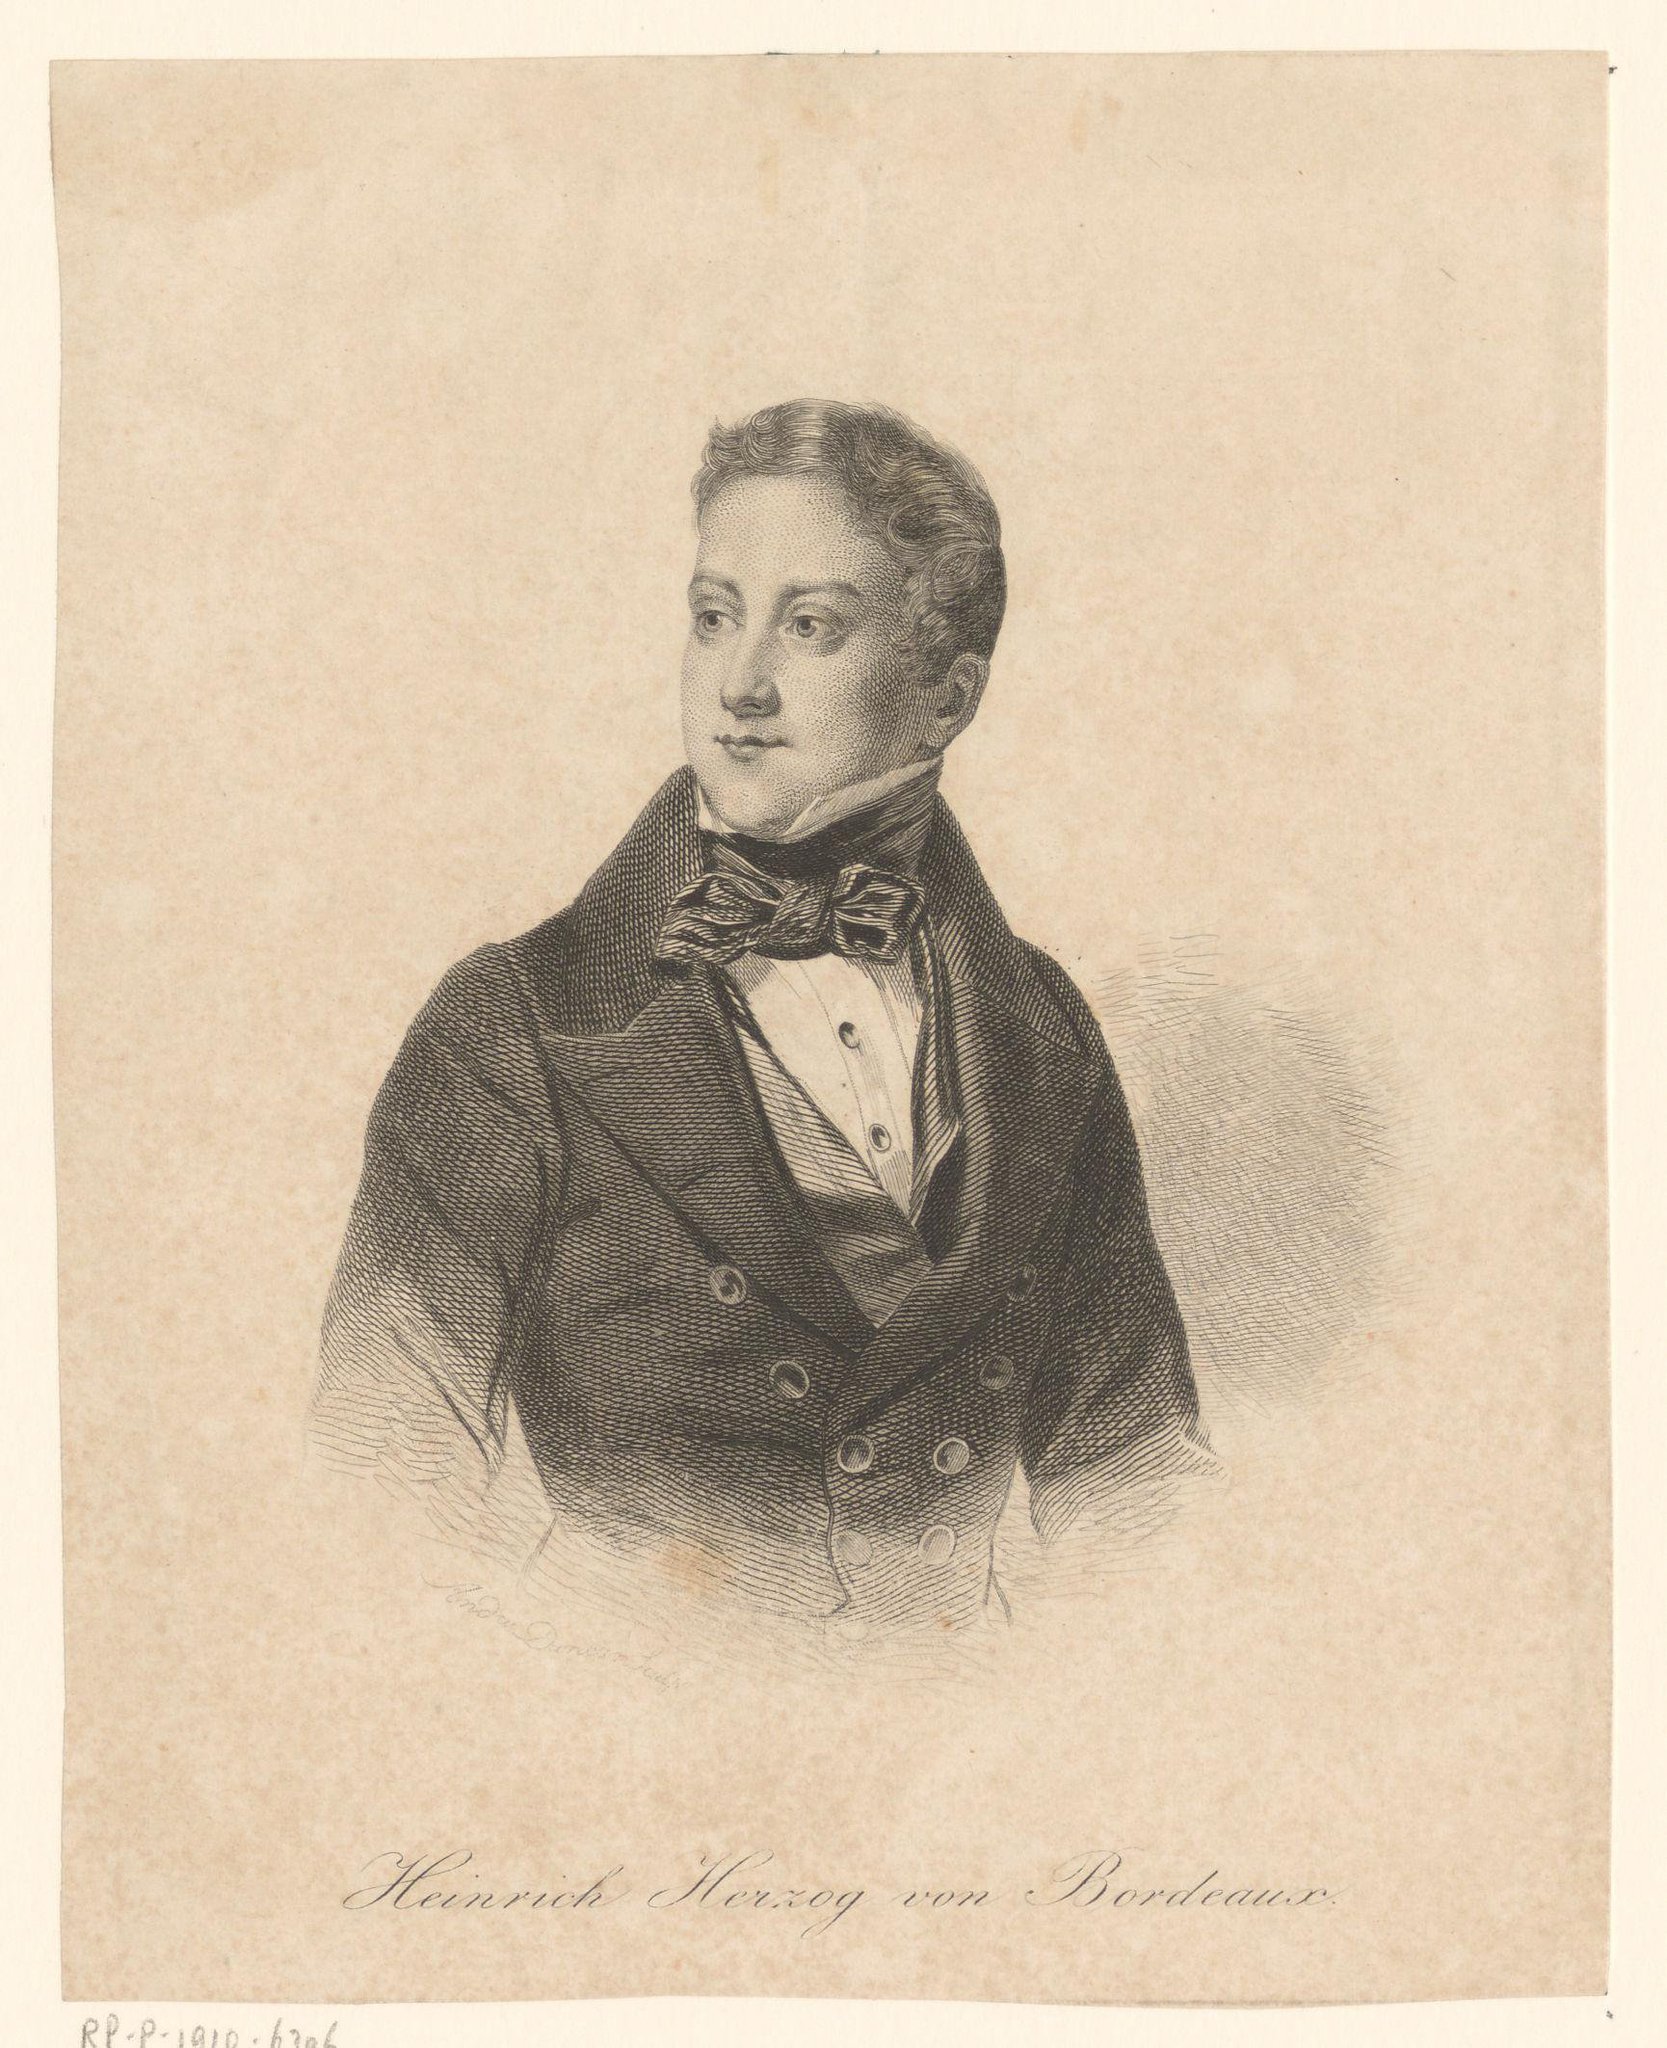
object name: print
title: Heinrich Herzog von Bordeaux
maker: andrew duncan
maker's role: print maker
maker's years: 1795-1855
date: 1830-1895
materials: paper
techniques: engraving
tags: paris, historical persons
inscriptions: collector's mark: Lugt 2228